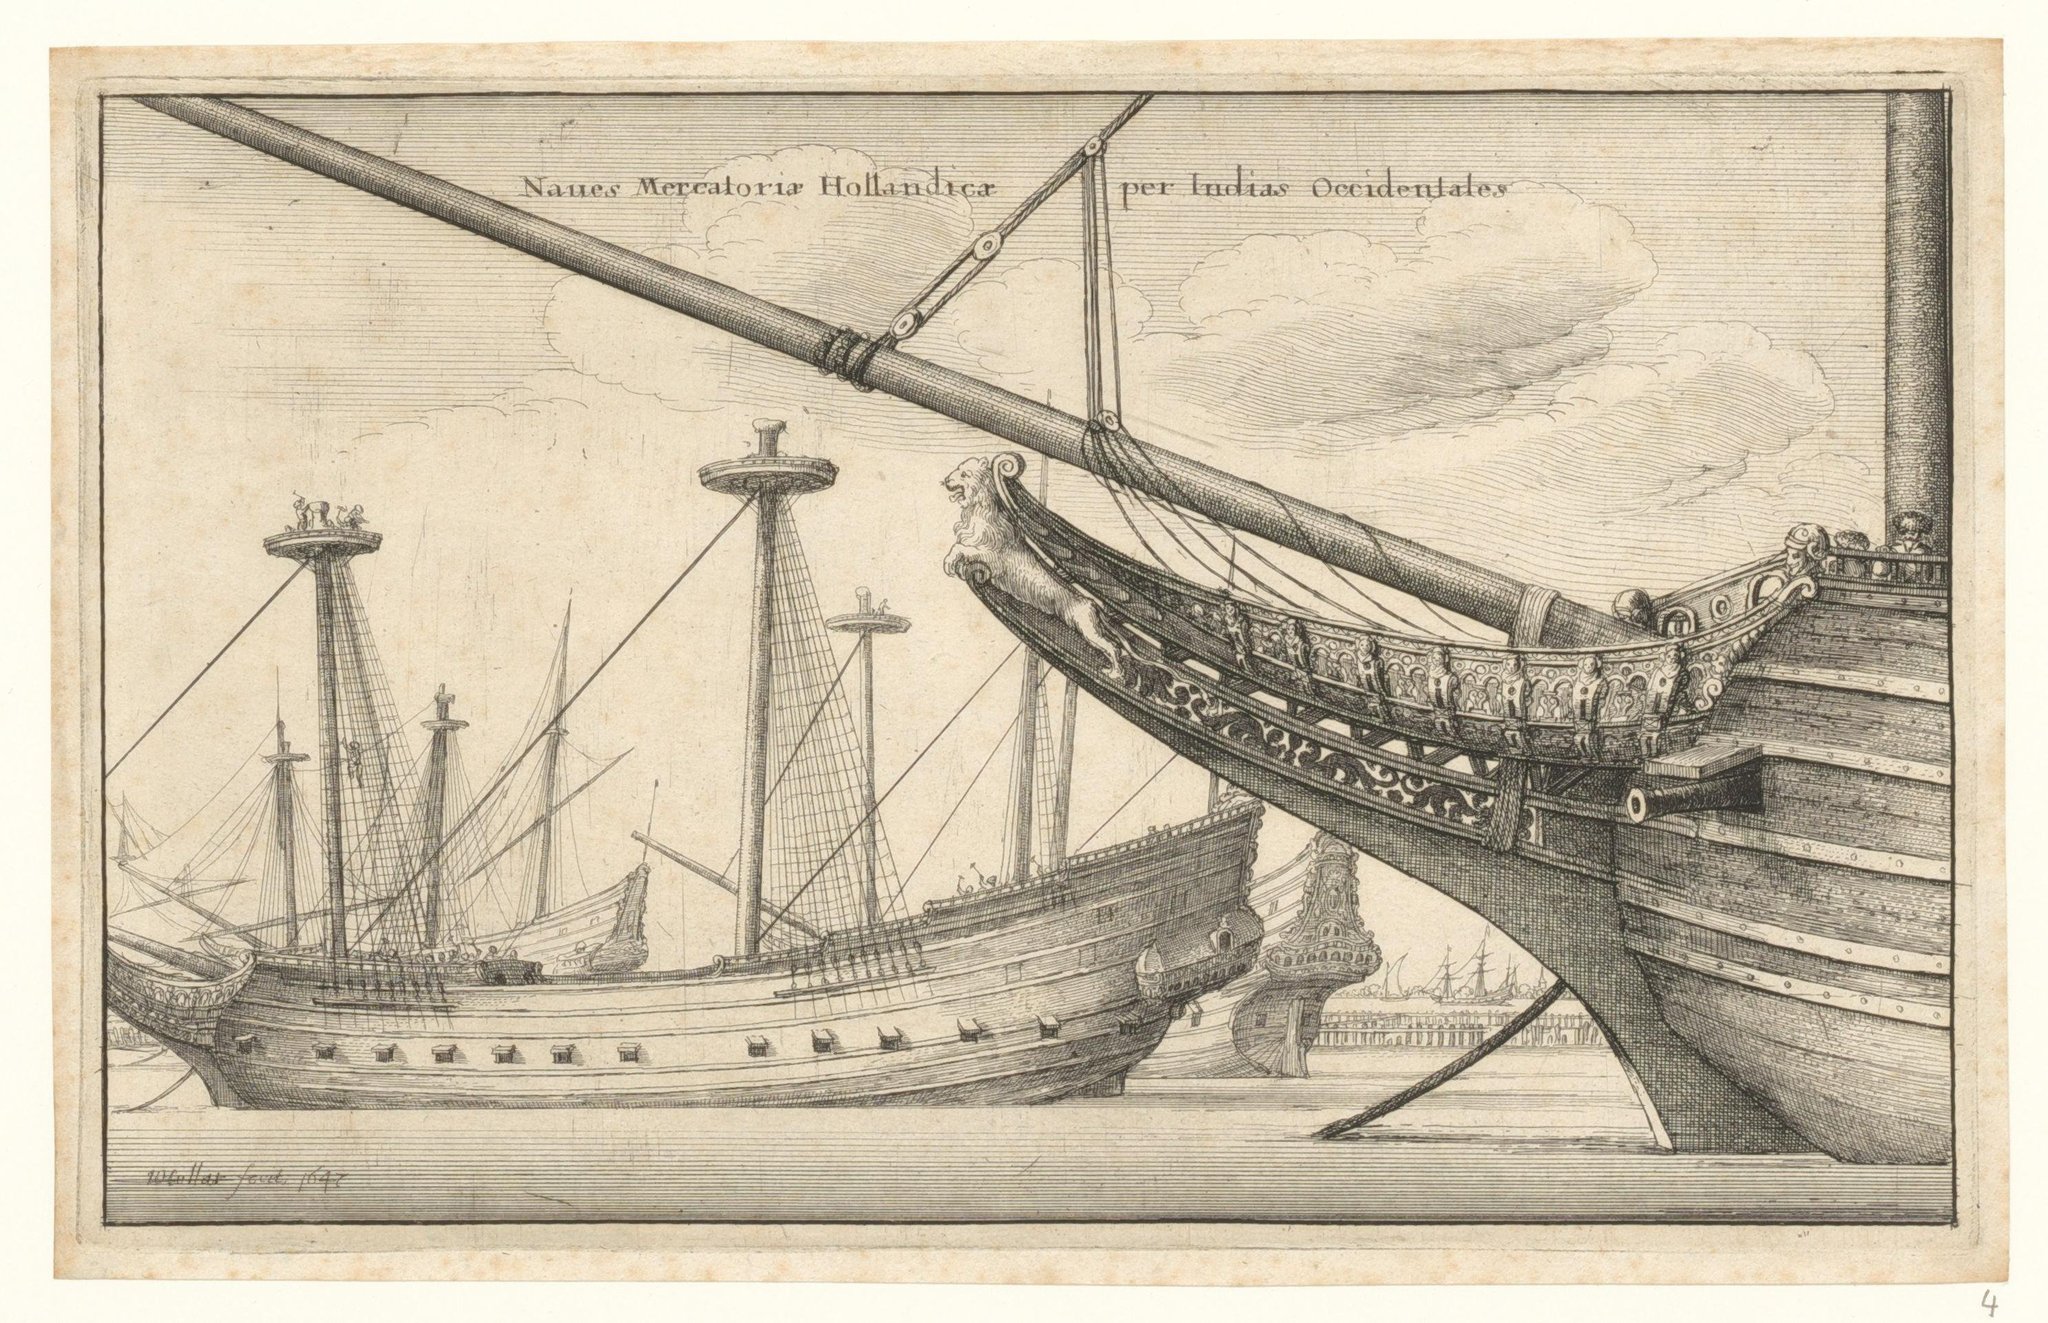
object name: print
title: Verschillende Nederlandse scheepstypen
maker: wenceslaus hollar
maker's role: draughtsman, print maker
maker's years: 1607-1677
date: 1647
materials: paper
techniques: etching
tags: parts of ship's exterior: bow, sailing-ship, sailing-boat (westindiaman)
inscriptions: collector's mark: Lugt 1641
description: Onderwerpsrubrieken binnen de Atlas Zeden en Gewoonten: Handel, Nijverheid en Verkeer, Scheepsbouw.